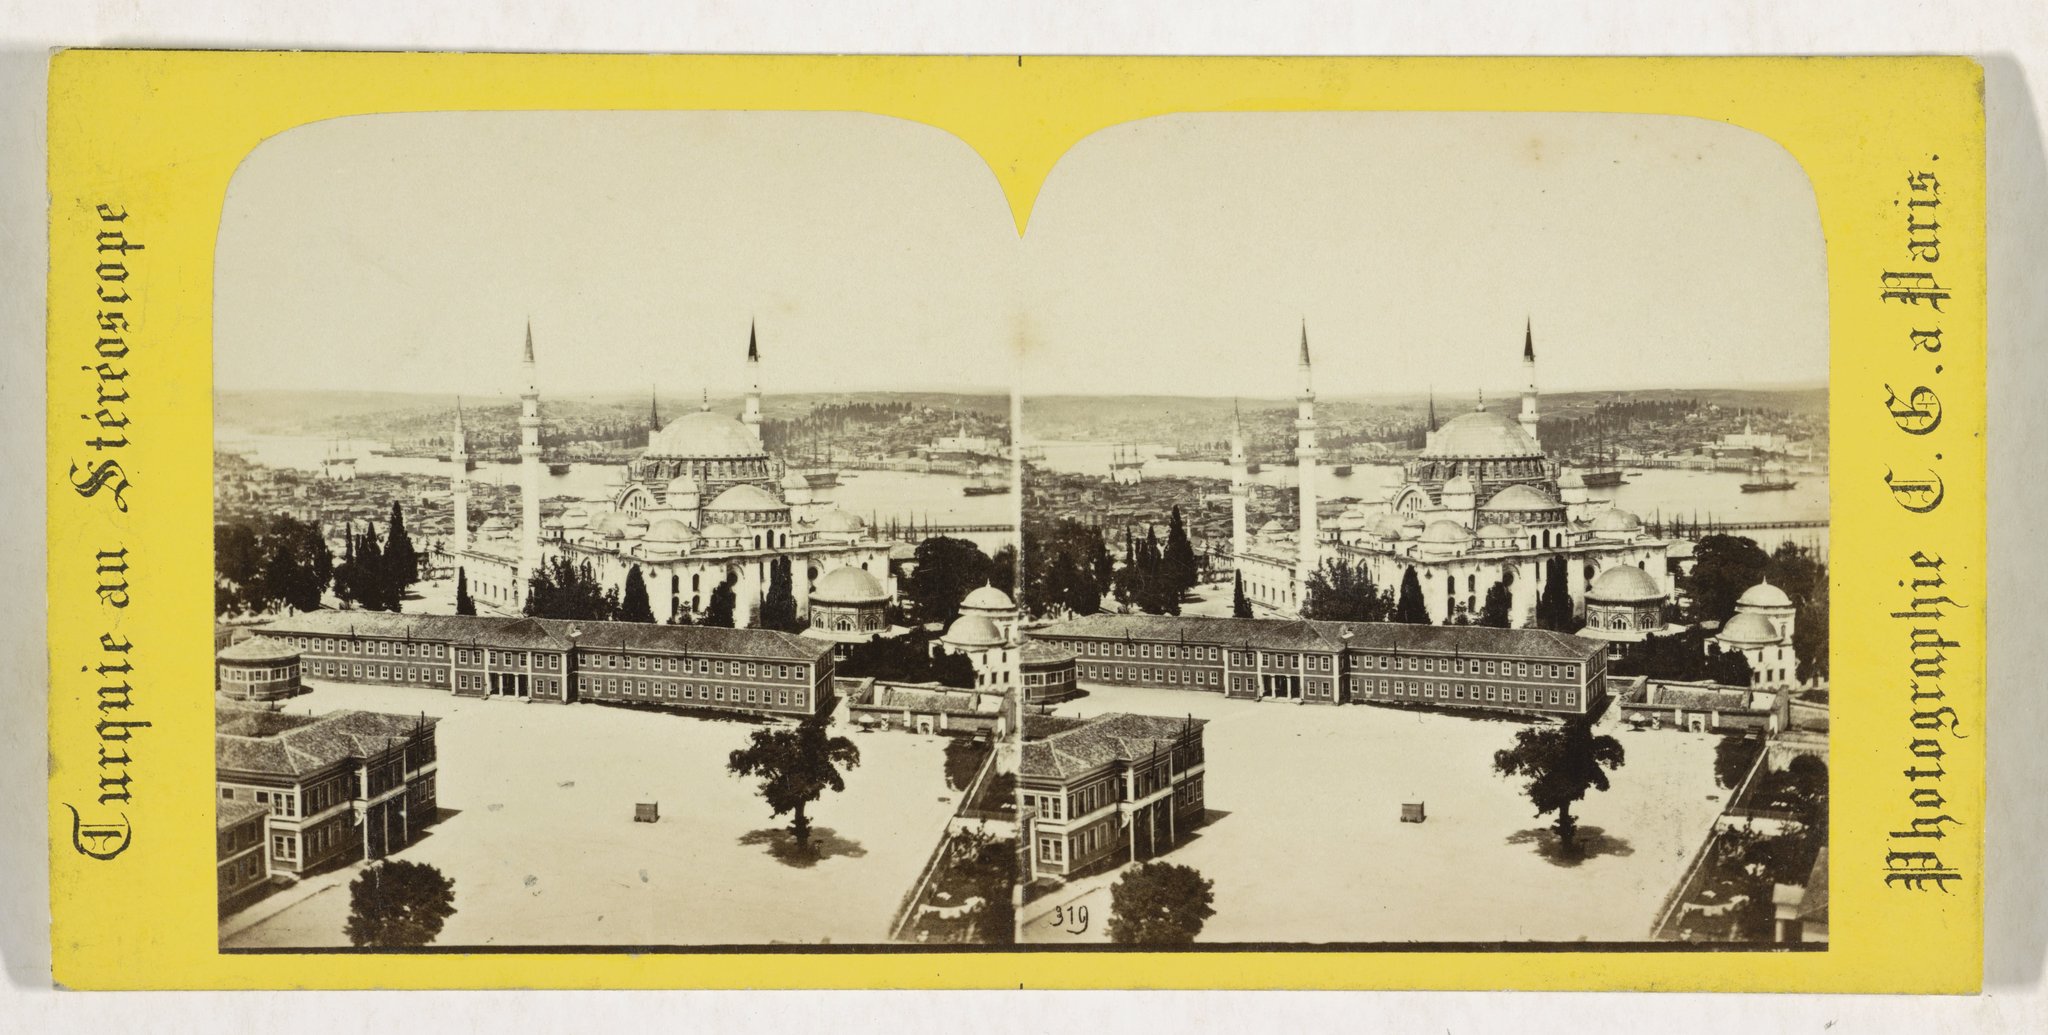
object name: stereograph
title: Vue générale de Constantinople avec la mosquée de Suleiman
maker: charles gaudin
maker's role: publisher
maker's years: 1825-1905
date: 1861-1870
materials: cardboard, paper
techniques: albumen print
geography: süleymaniye-moskee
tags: temple, shrine ~ islam, mohammedanism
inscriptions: number: ‘319’